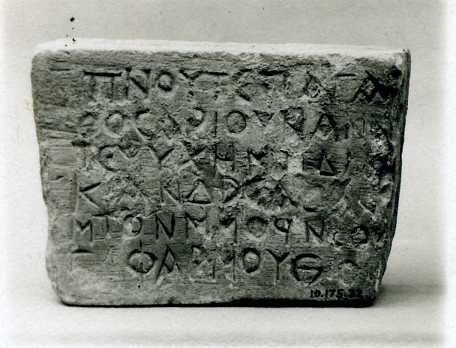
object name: stele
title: Fragment of an Inscribed Stele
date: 501-700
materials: limestone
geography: egypt